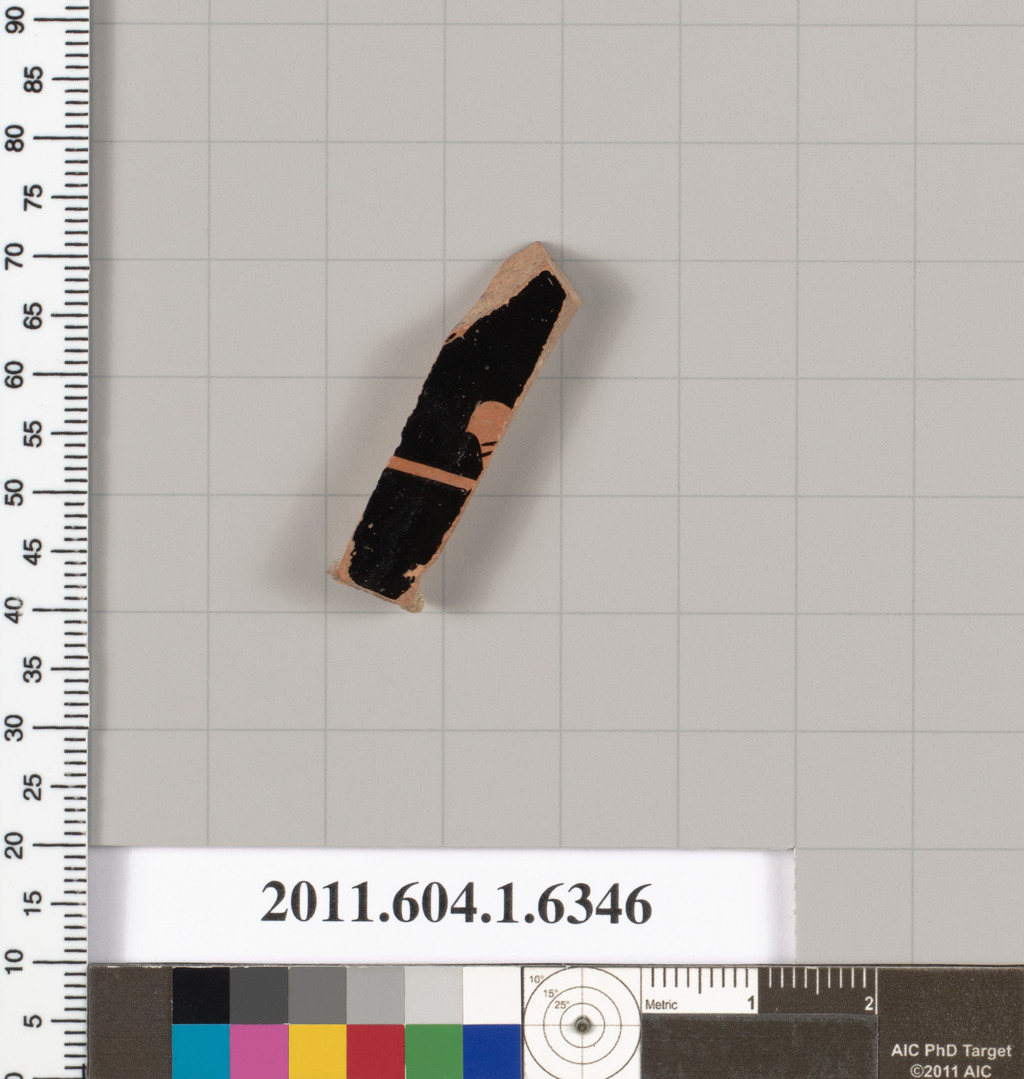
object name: kylix fragment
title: Terracotta fragment of a kylix (drinking cup)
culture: greek, attic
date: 500-480 BCE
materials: terracotta